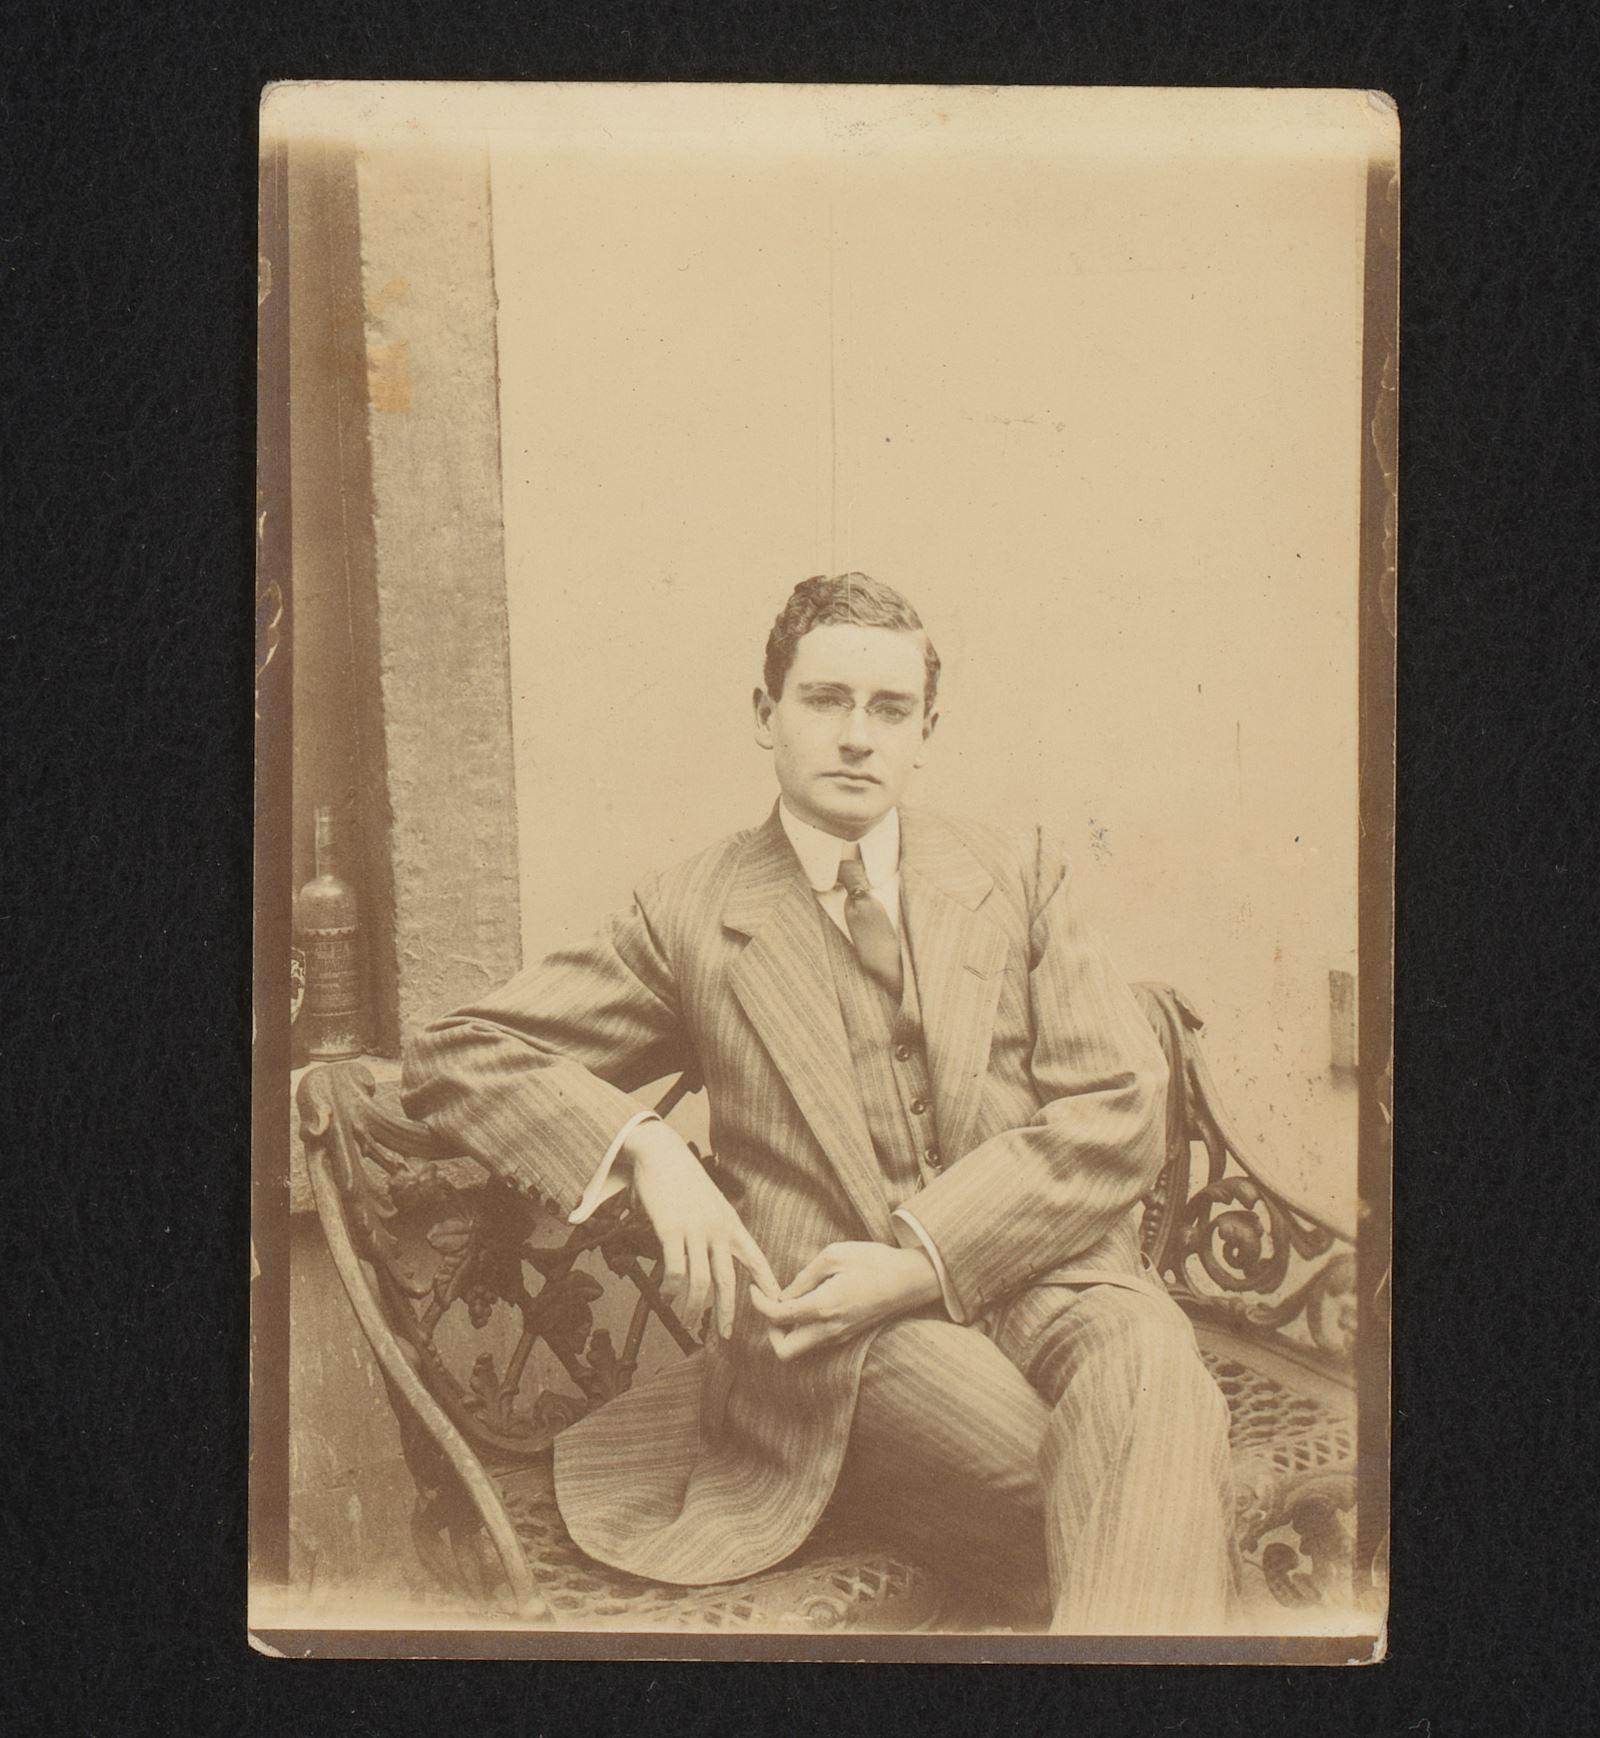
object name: album leaf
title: Portret van een man met bril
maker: Anonymous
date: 1910-1930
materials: paper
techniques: gelatin silver print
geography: france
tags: adult man, historical persons, france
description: Over de foto is een ander negatief afgedrukt van een voorstelling van bomen.